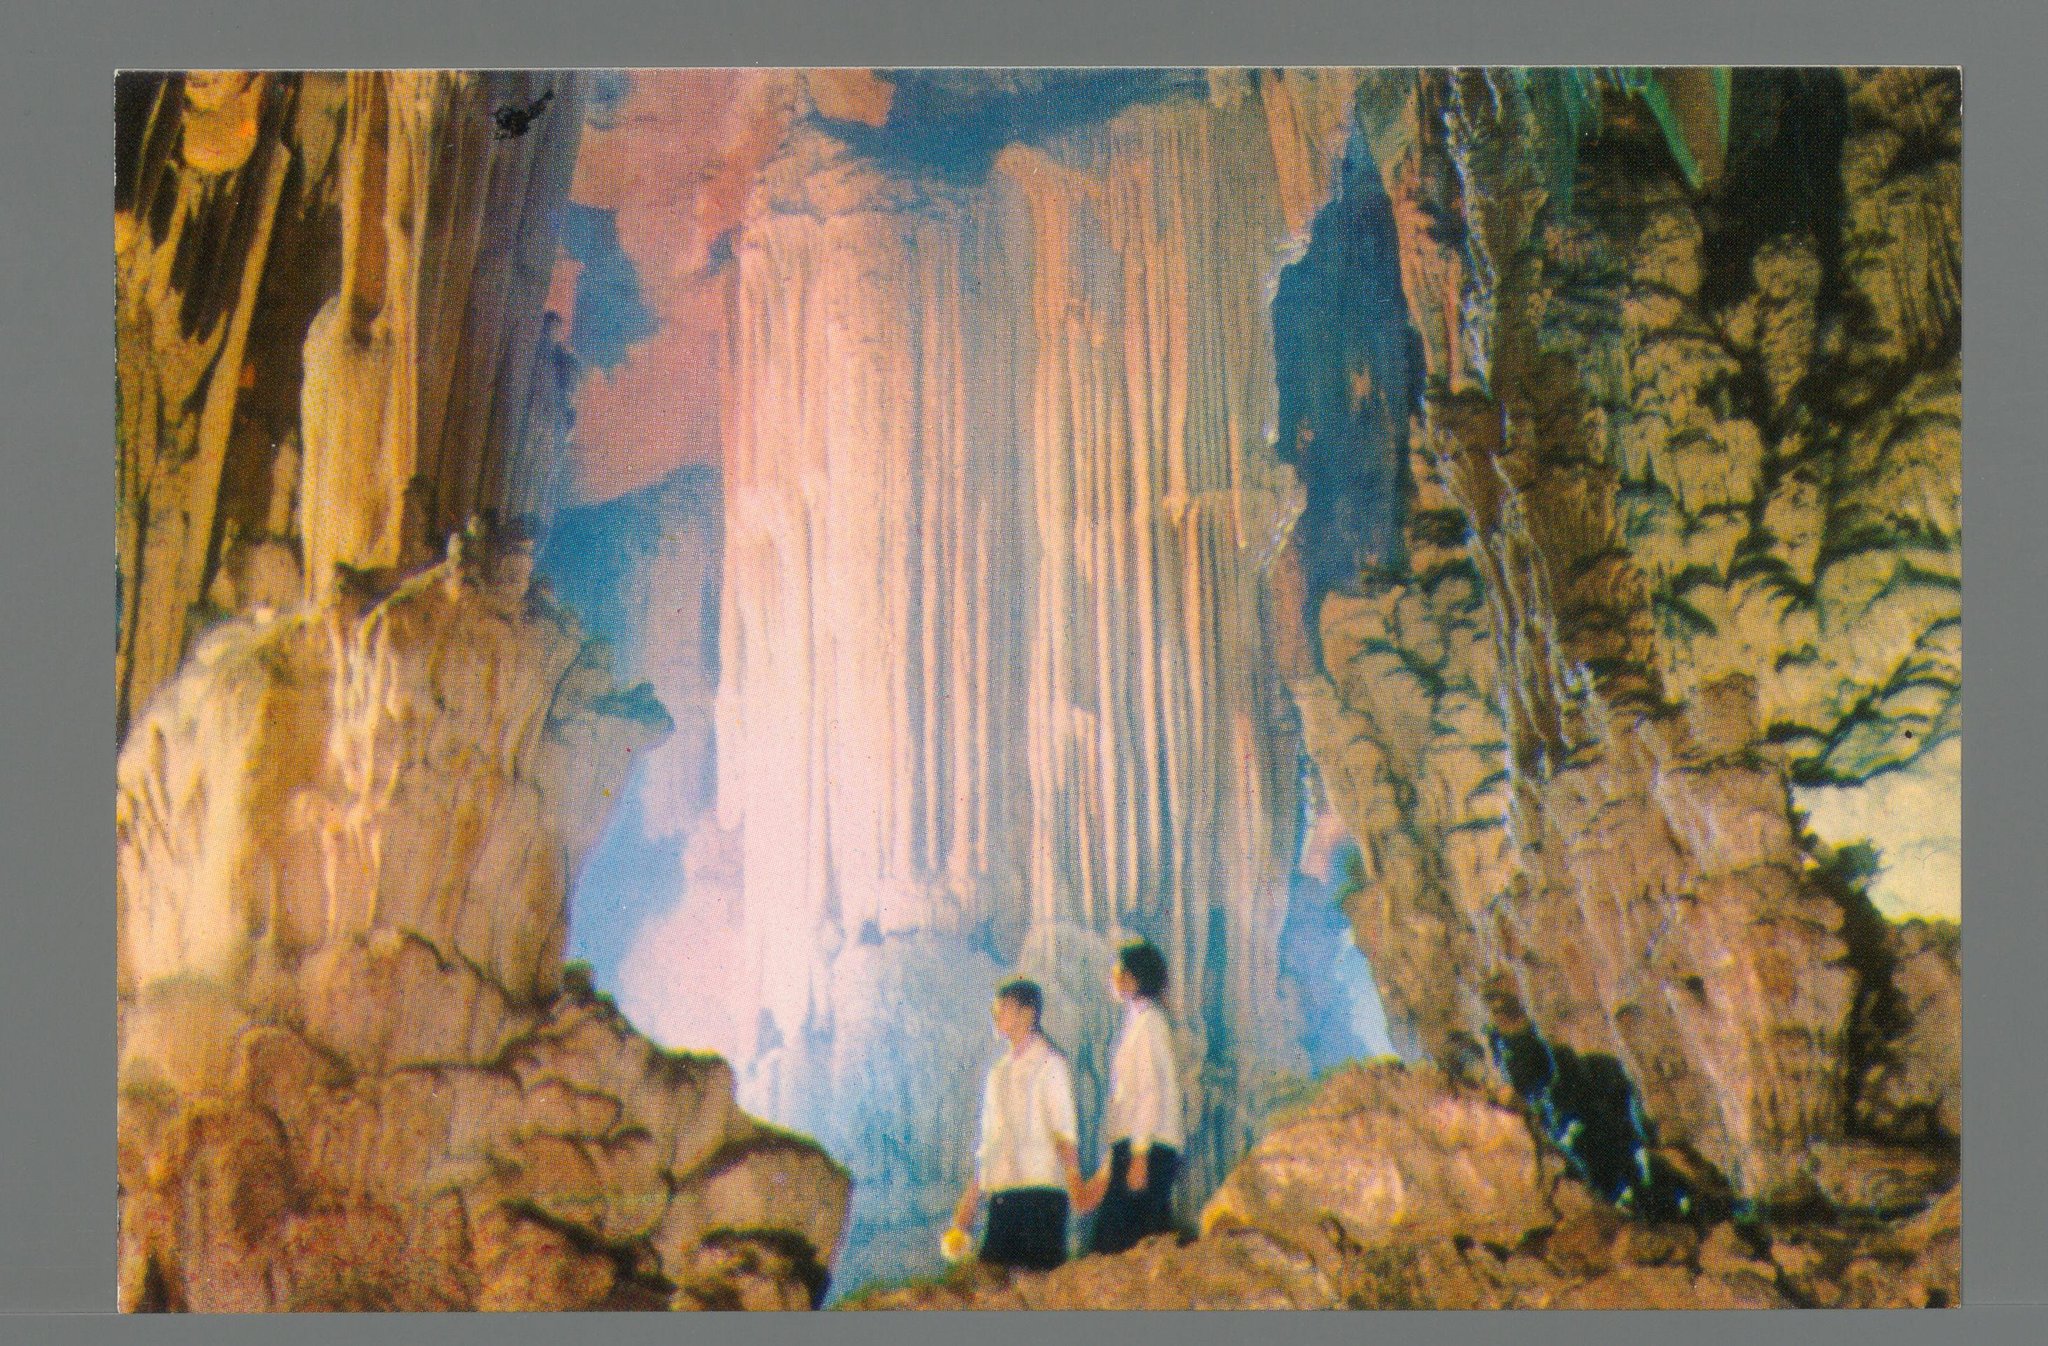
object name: ansichtkaart, prentbriefkaart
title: Dripstones in Reed Flute Cavern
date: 1974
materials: cardboard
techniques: offset printed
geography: china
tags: stalactitic cave